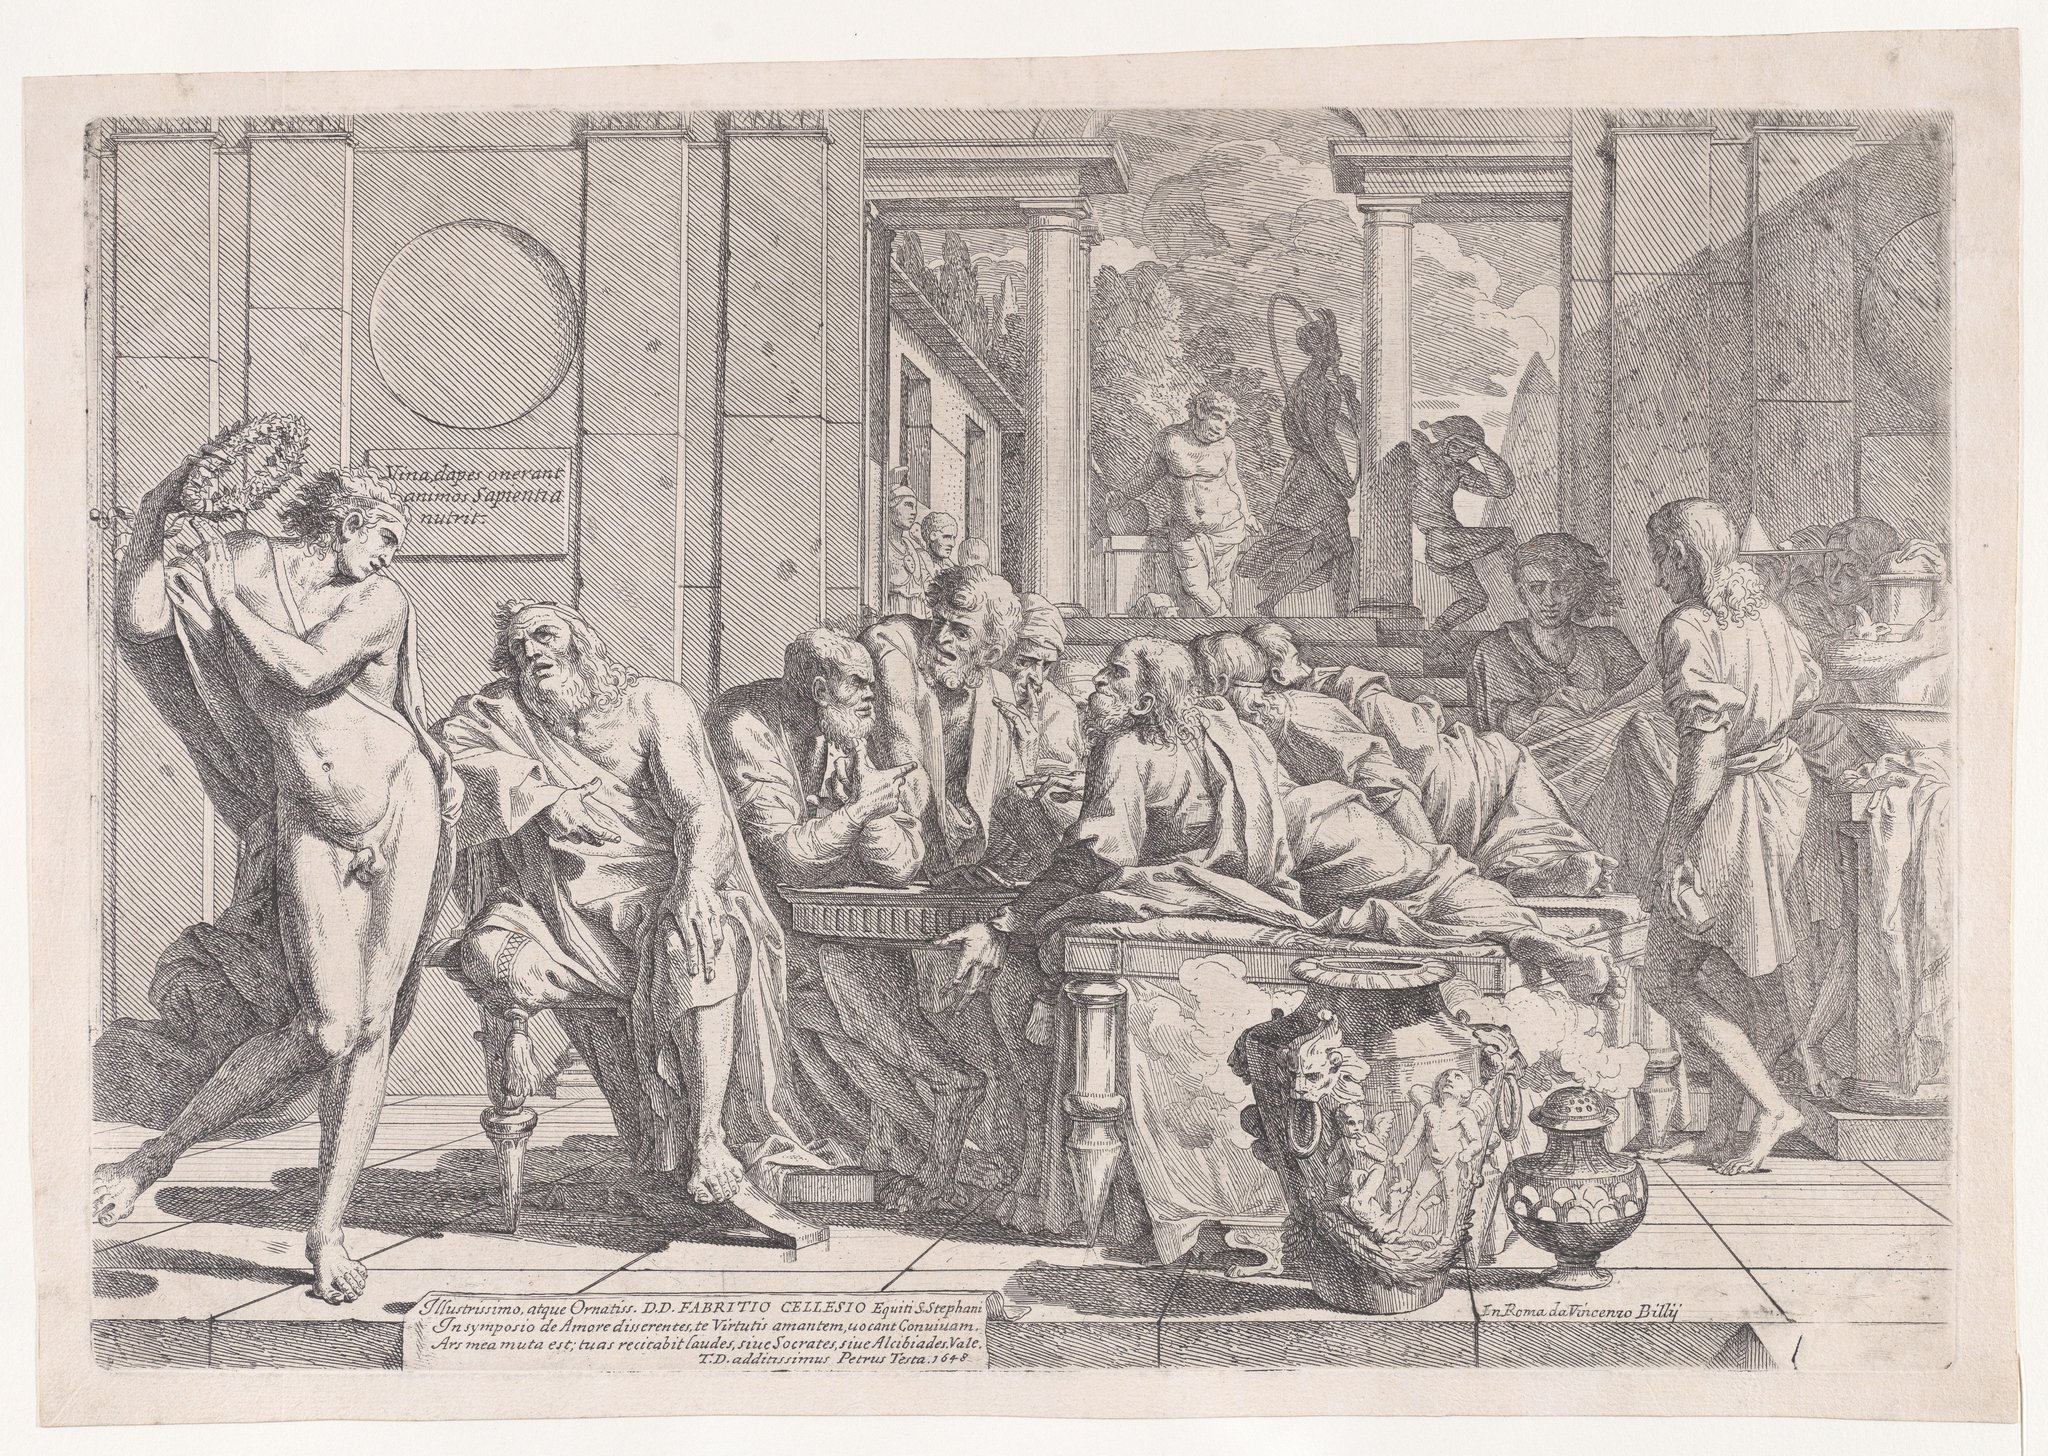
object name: print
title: Plato's symposium: Socrates and his companions seated around a table discussing ideal love interruputed by Acibiades at left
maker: pietro testa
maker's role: artist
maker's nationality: italian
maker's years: 1612-1650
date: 1648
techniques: etching